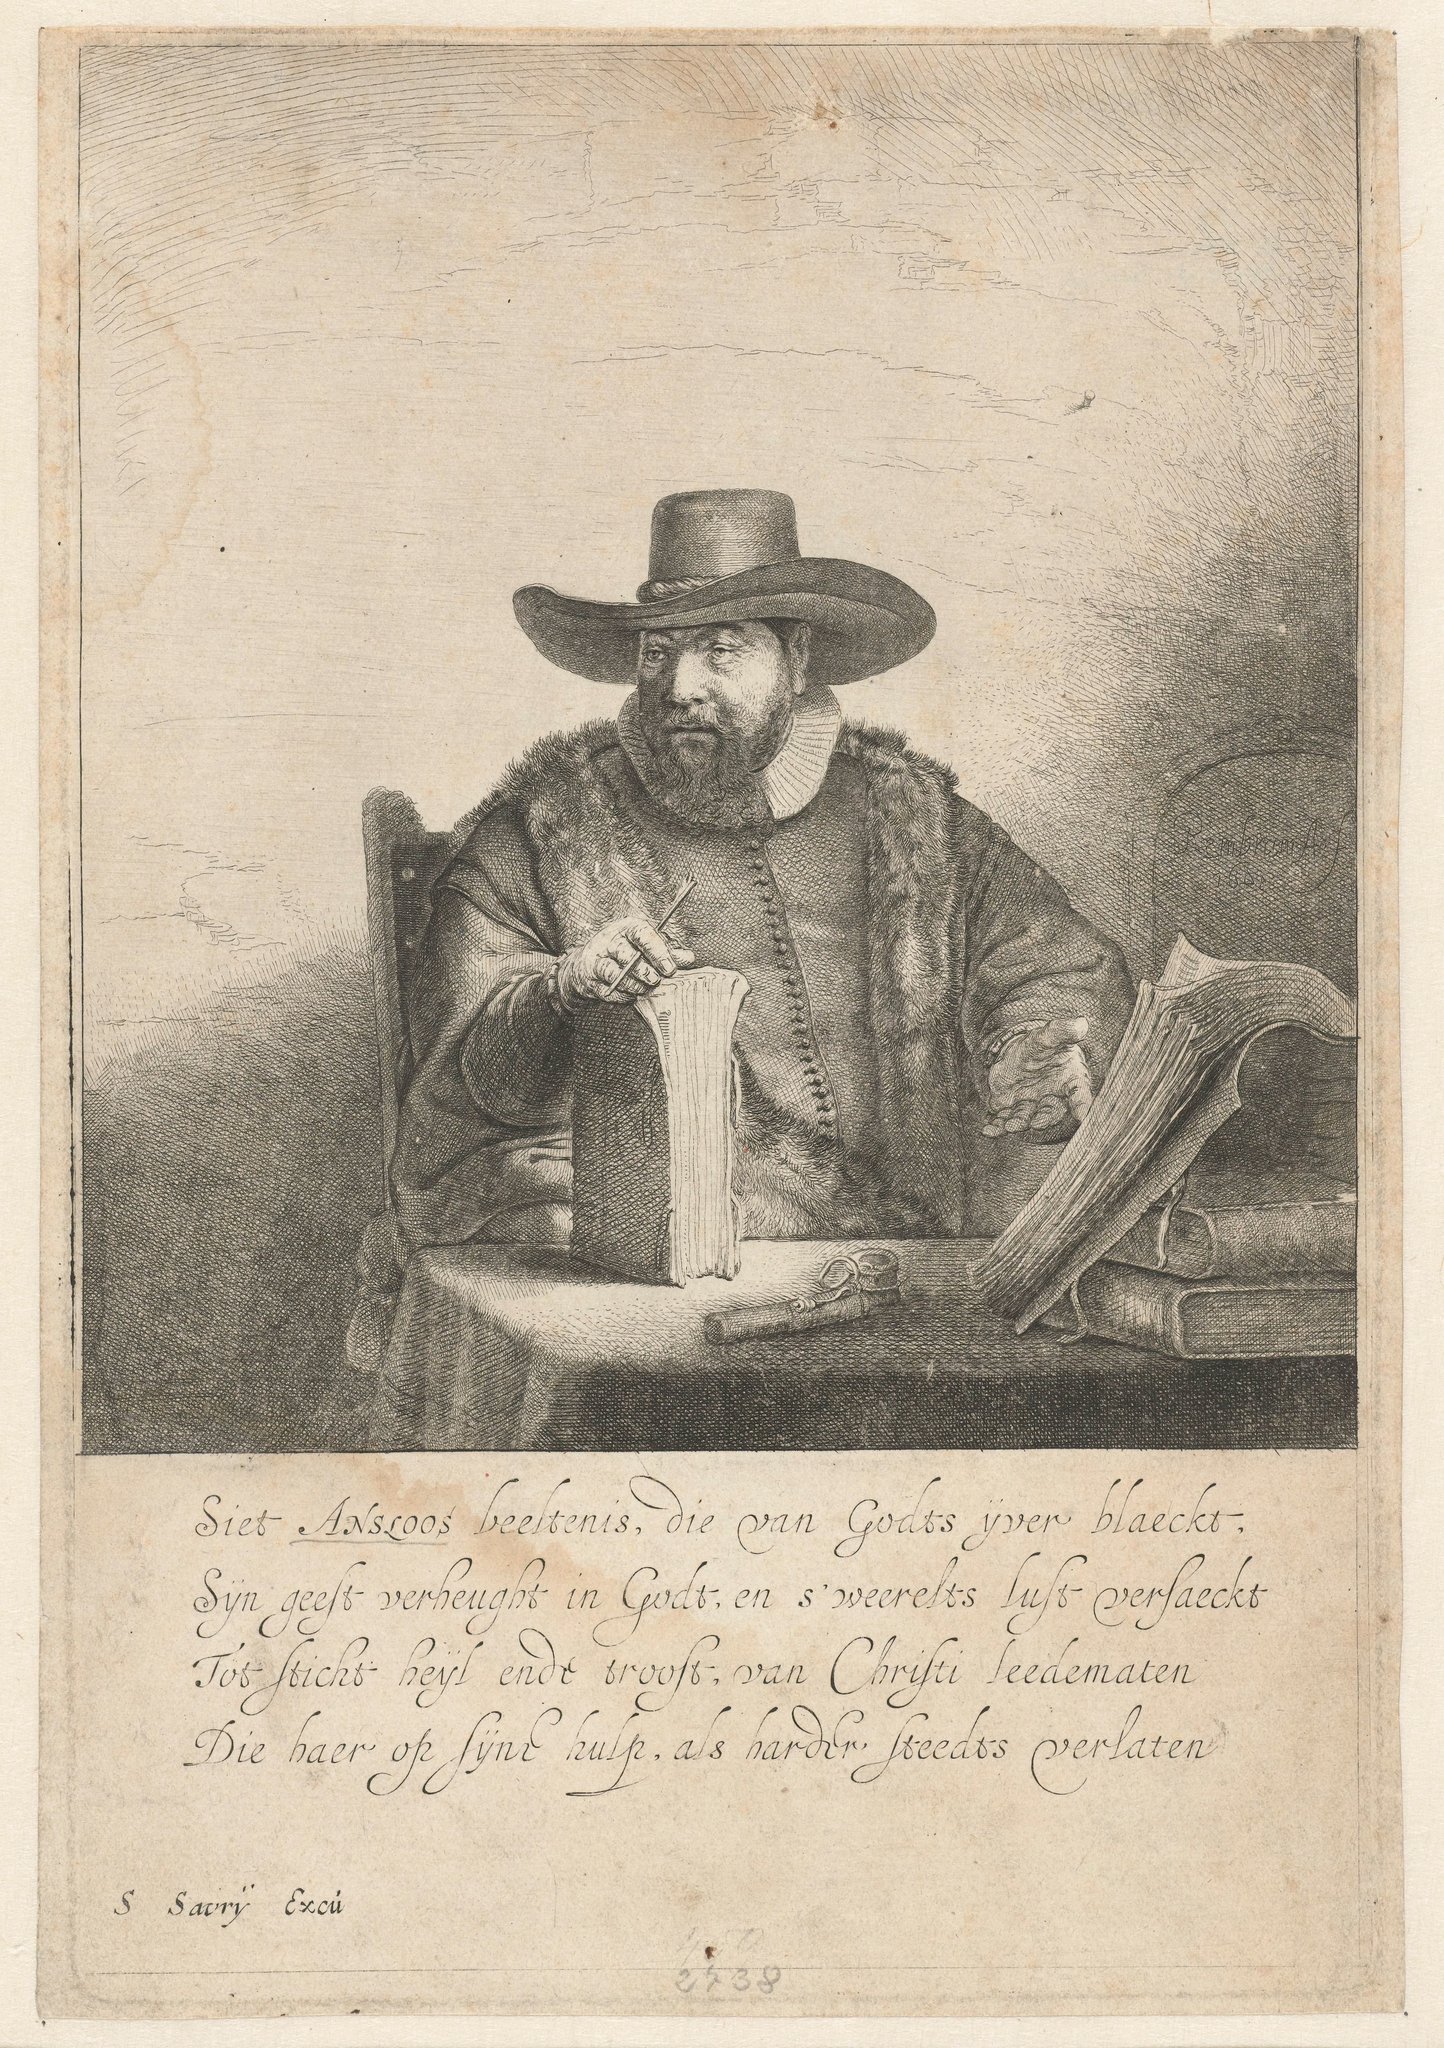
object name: print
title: Cornelis Claesz. Anslo, preacher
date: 1641-1683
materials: paper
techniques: engraving, etching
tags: historical persons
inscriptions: collector's mark: Lugt 2760, stamp, collector's mark: Lugt 2228